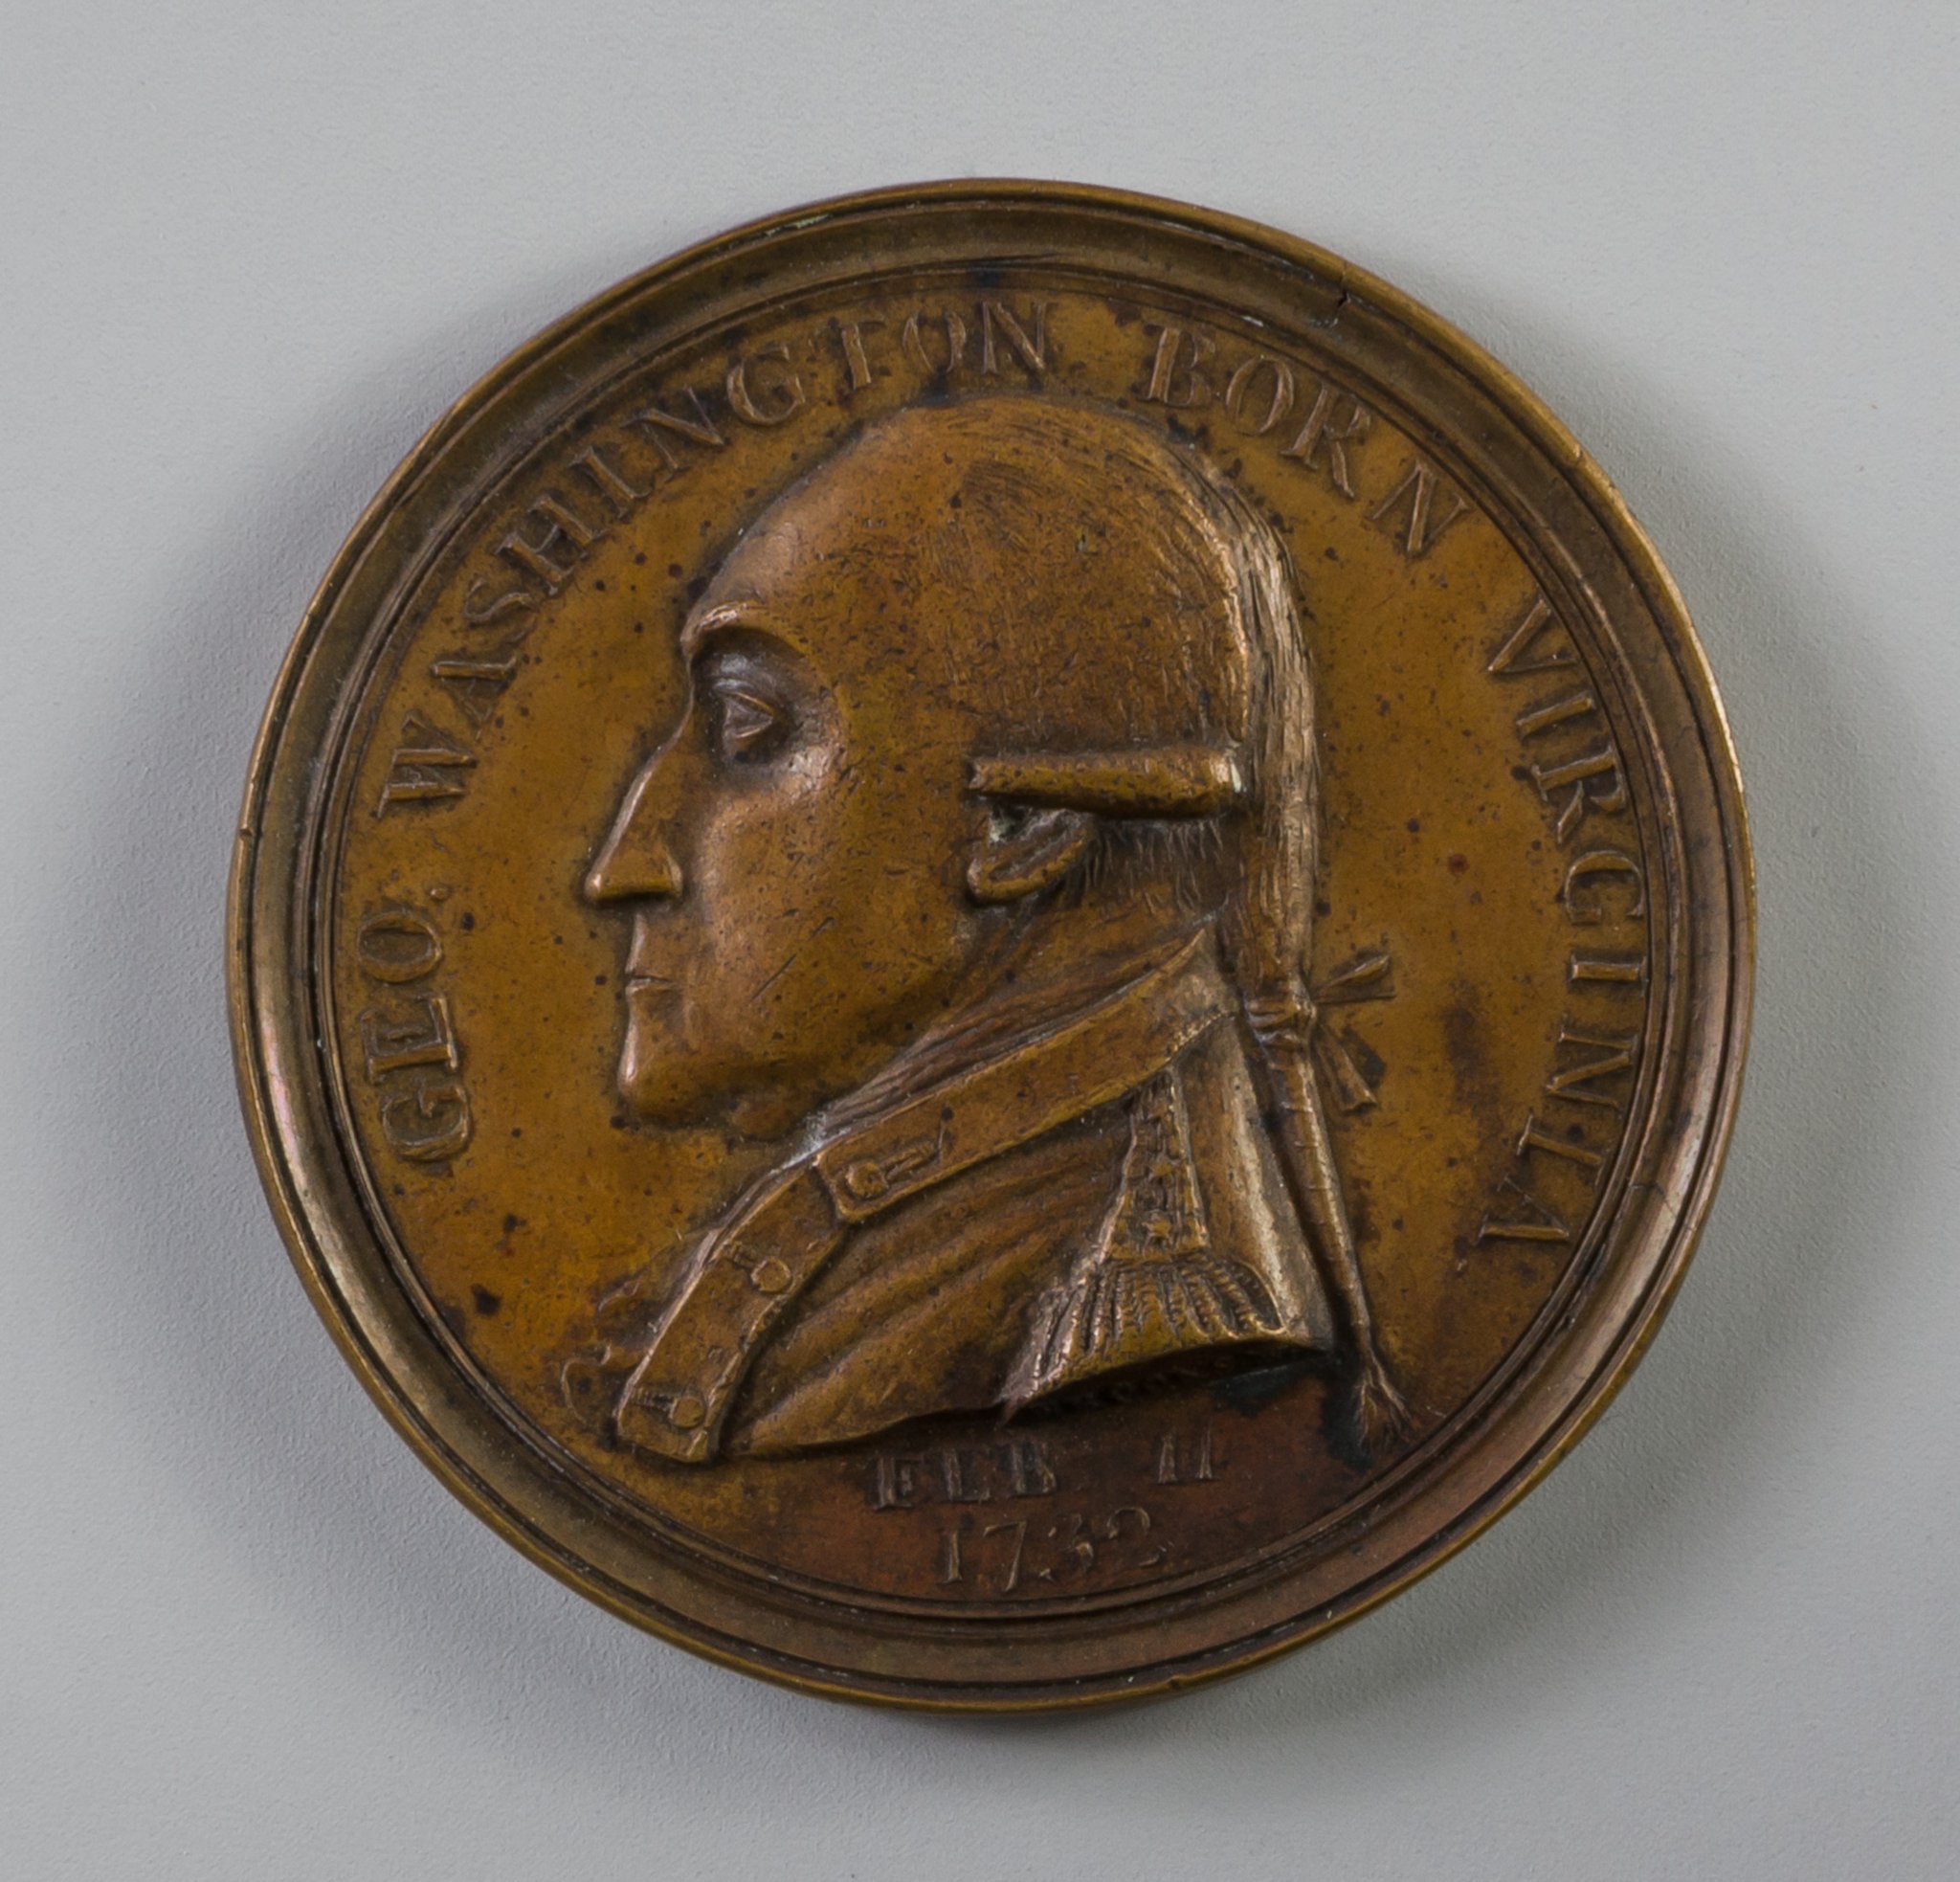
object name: medal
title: Medal of George Washington's Public Offices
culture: american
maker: james manley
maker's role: maker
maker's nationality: american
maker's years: 1790-1800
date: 1790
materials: gilt bronze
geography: united states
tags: george washington,profiles